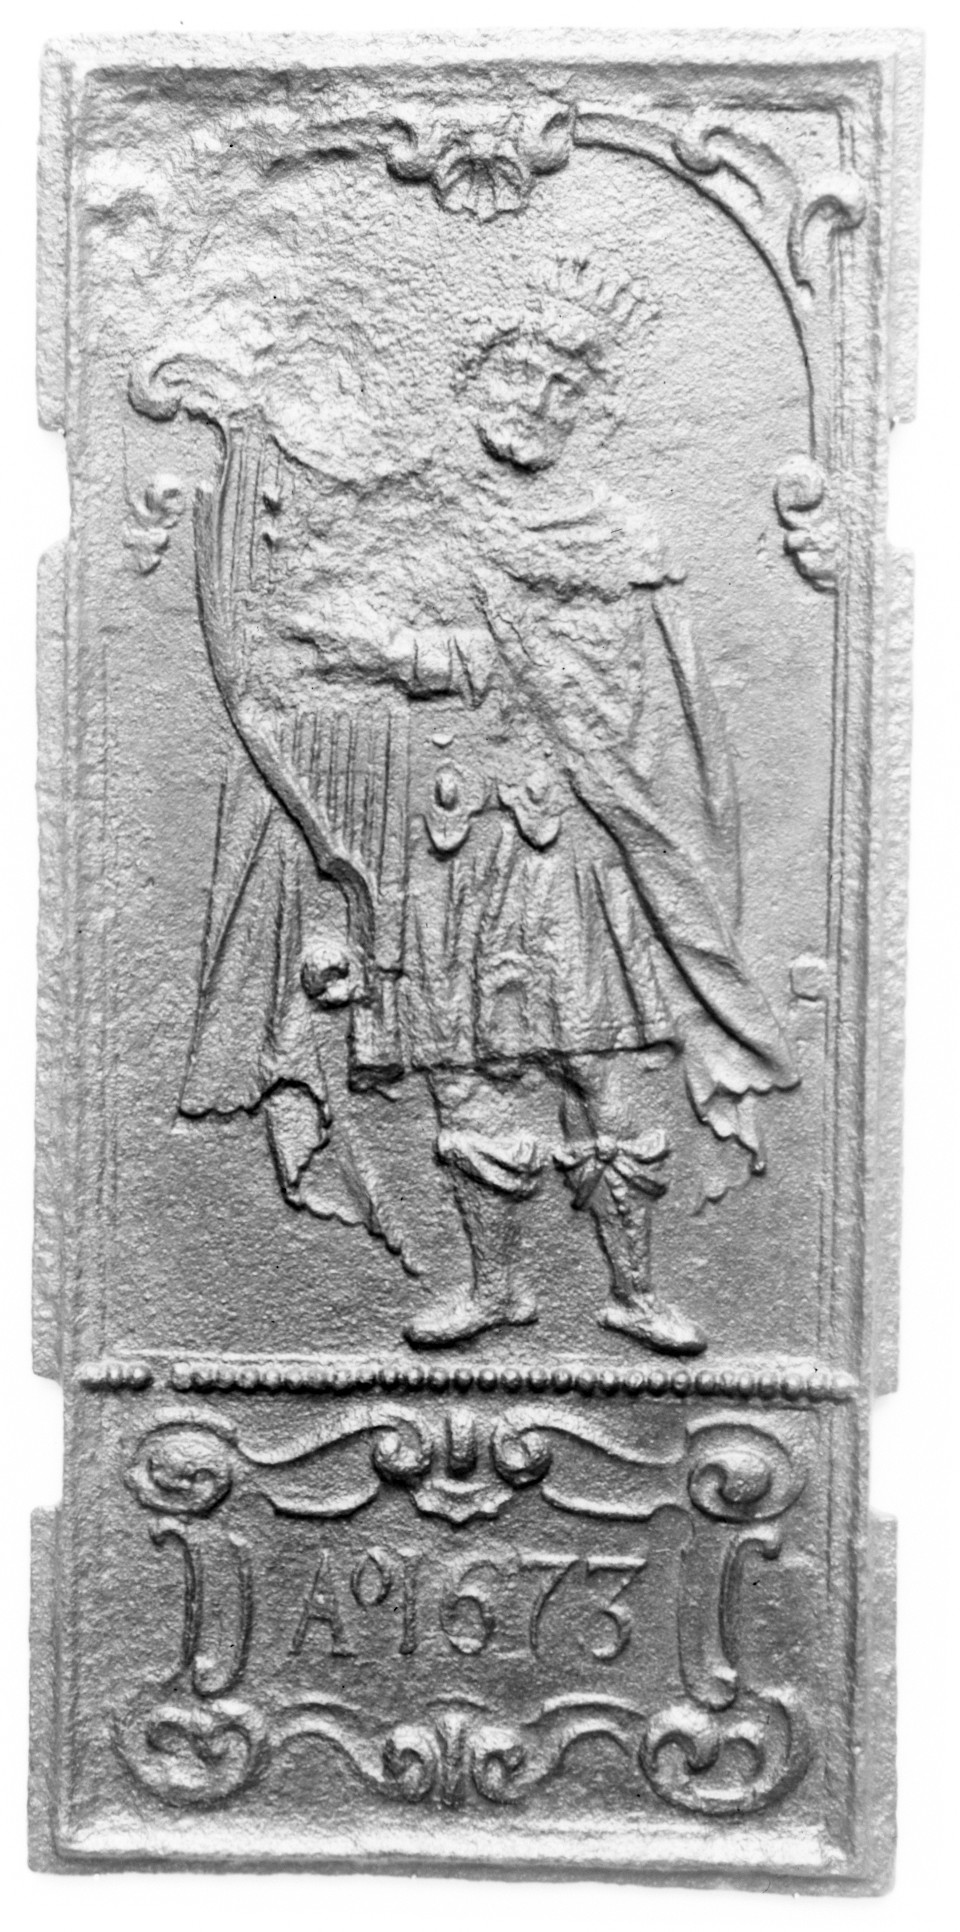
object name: stove plate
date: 1673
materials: iron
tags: men,harps